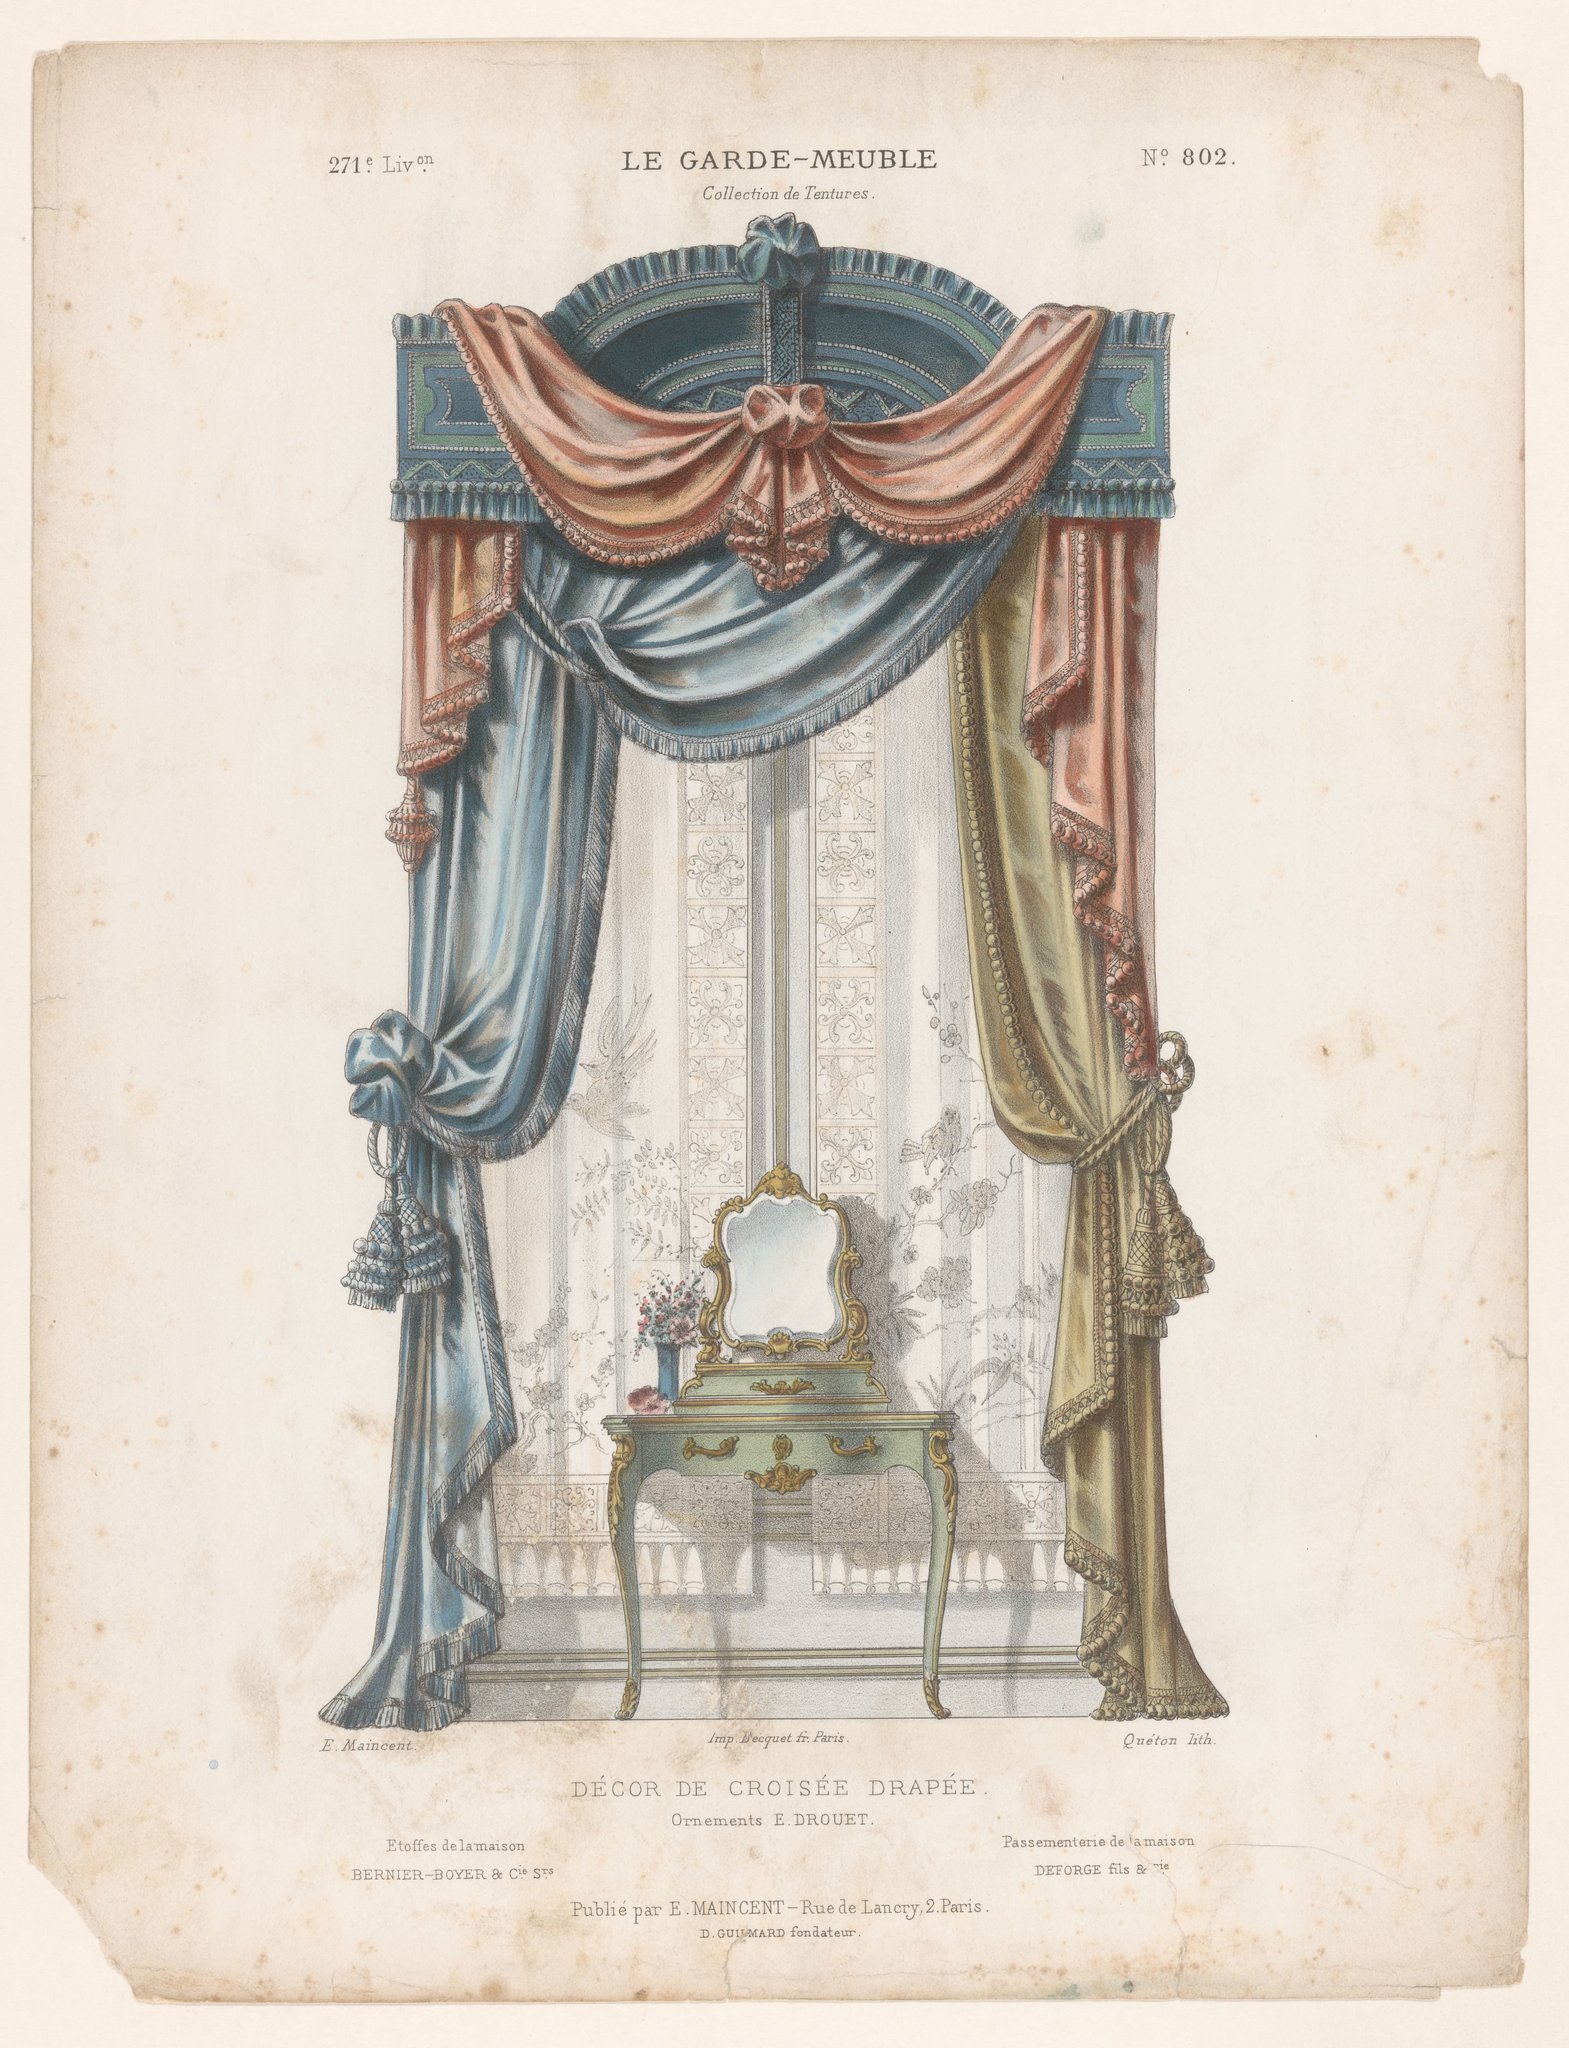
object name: print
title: Venster met gordijnen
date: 1885-1895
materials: paper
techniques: hand coloring, lithograph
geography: paris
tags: window, hangings and drapery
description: Kruisvenster met gedrapeerde gordijnen. Prent uit 271e Livraison.